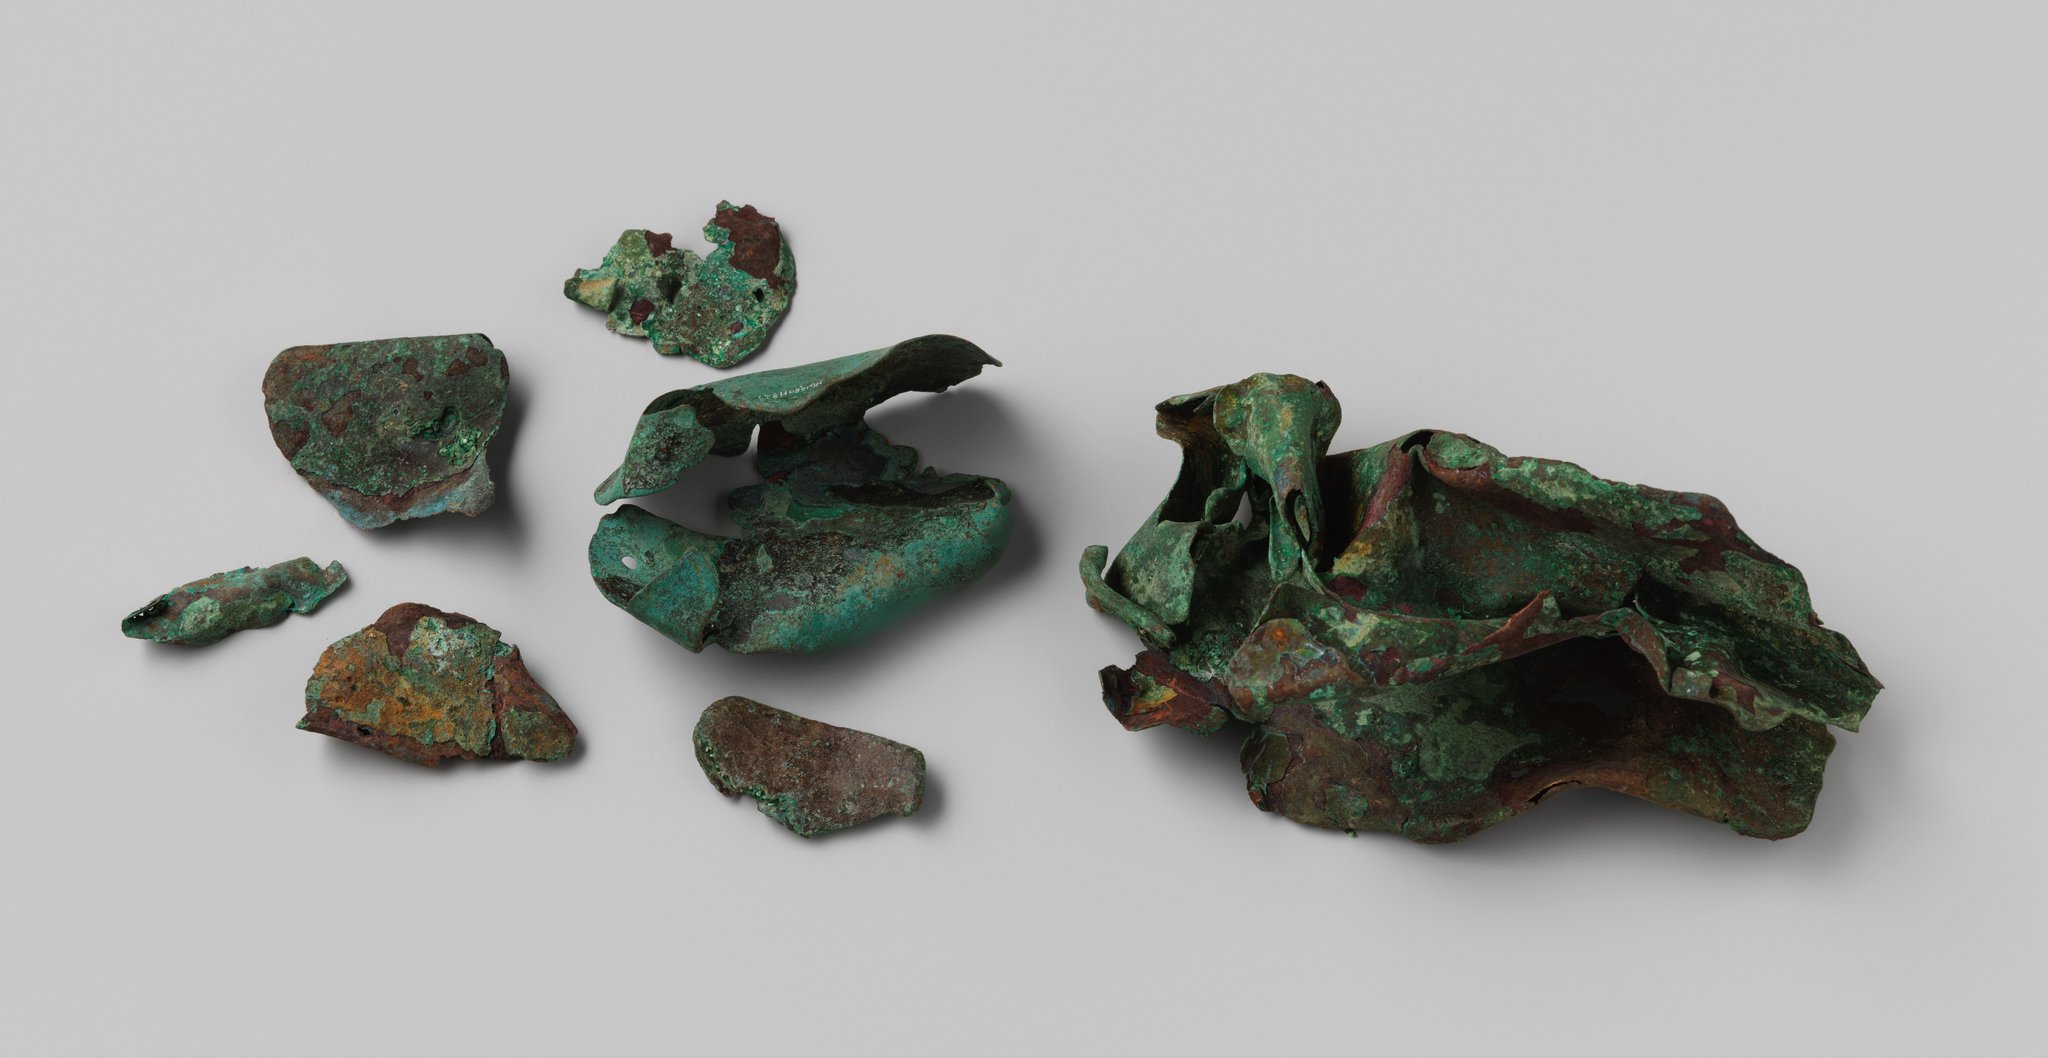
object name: fragment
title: Fragmenten koperen plaatwerk uit het wrak van de Oost-Indiëvaarder Hollandia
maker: Anonymous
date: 1700-1743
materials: copper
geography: netherlands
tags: verenigde oostindische compagnie, hollandia (schip), annet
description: Varied parts or fragments, sheet metal fragments: worked, with circular, rectangular or square holes; fragm, squashed, eroded, 1 nail-hole.